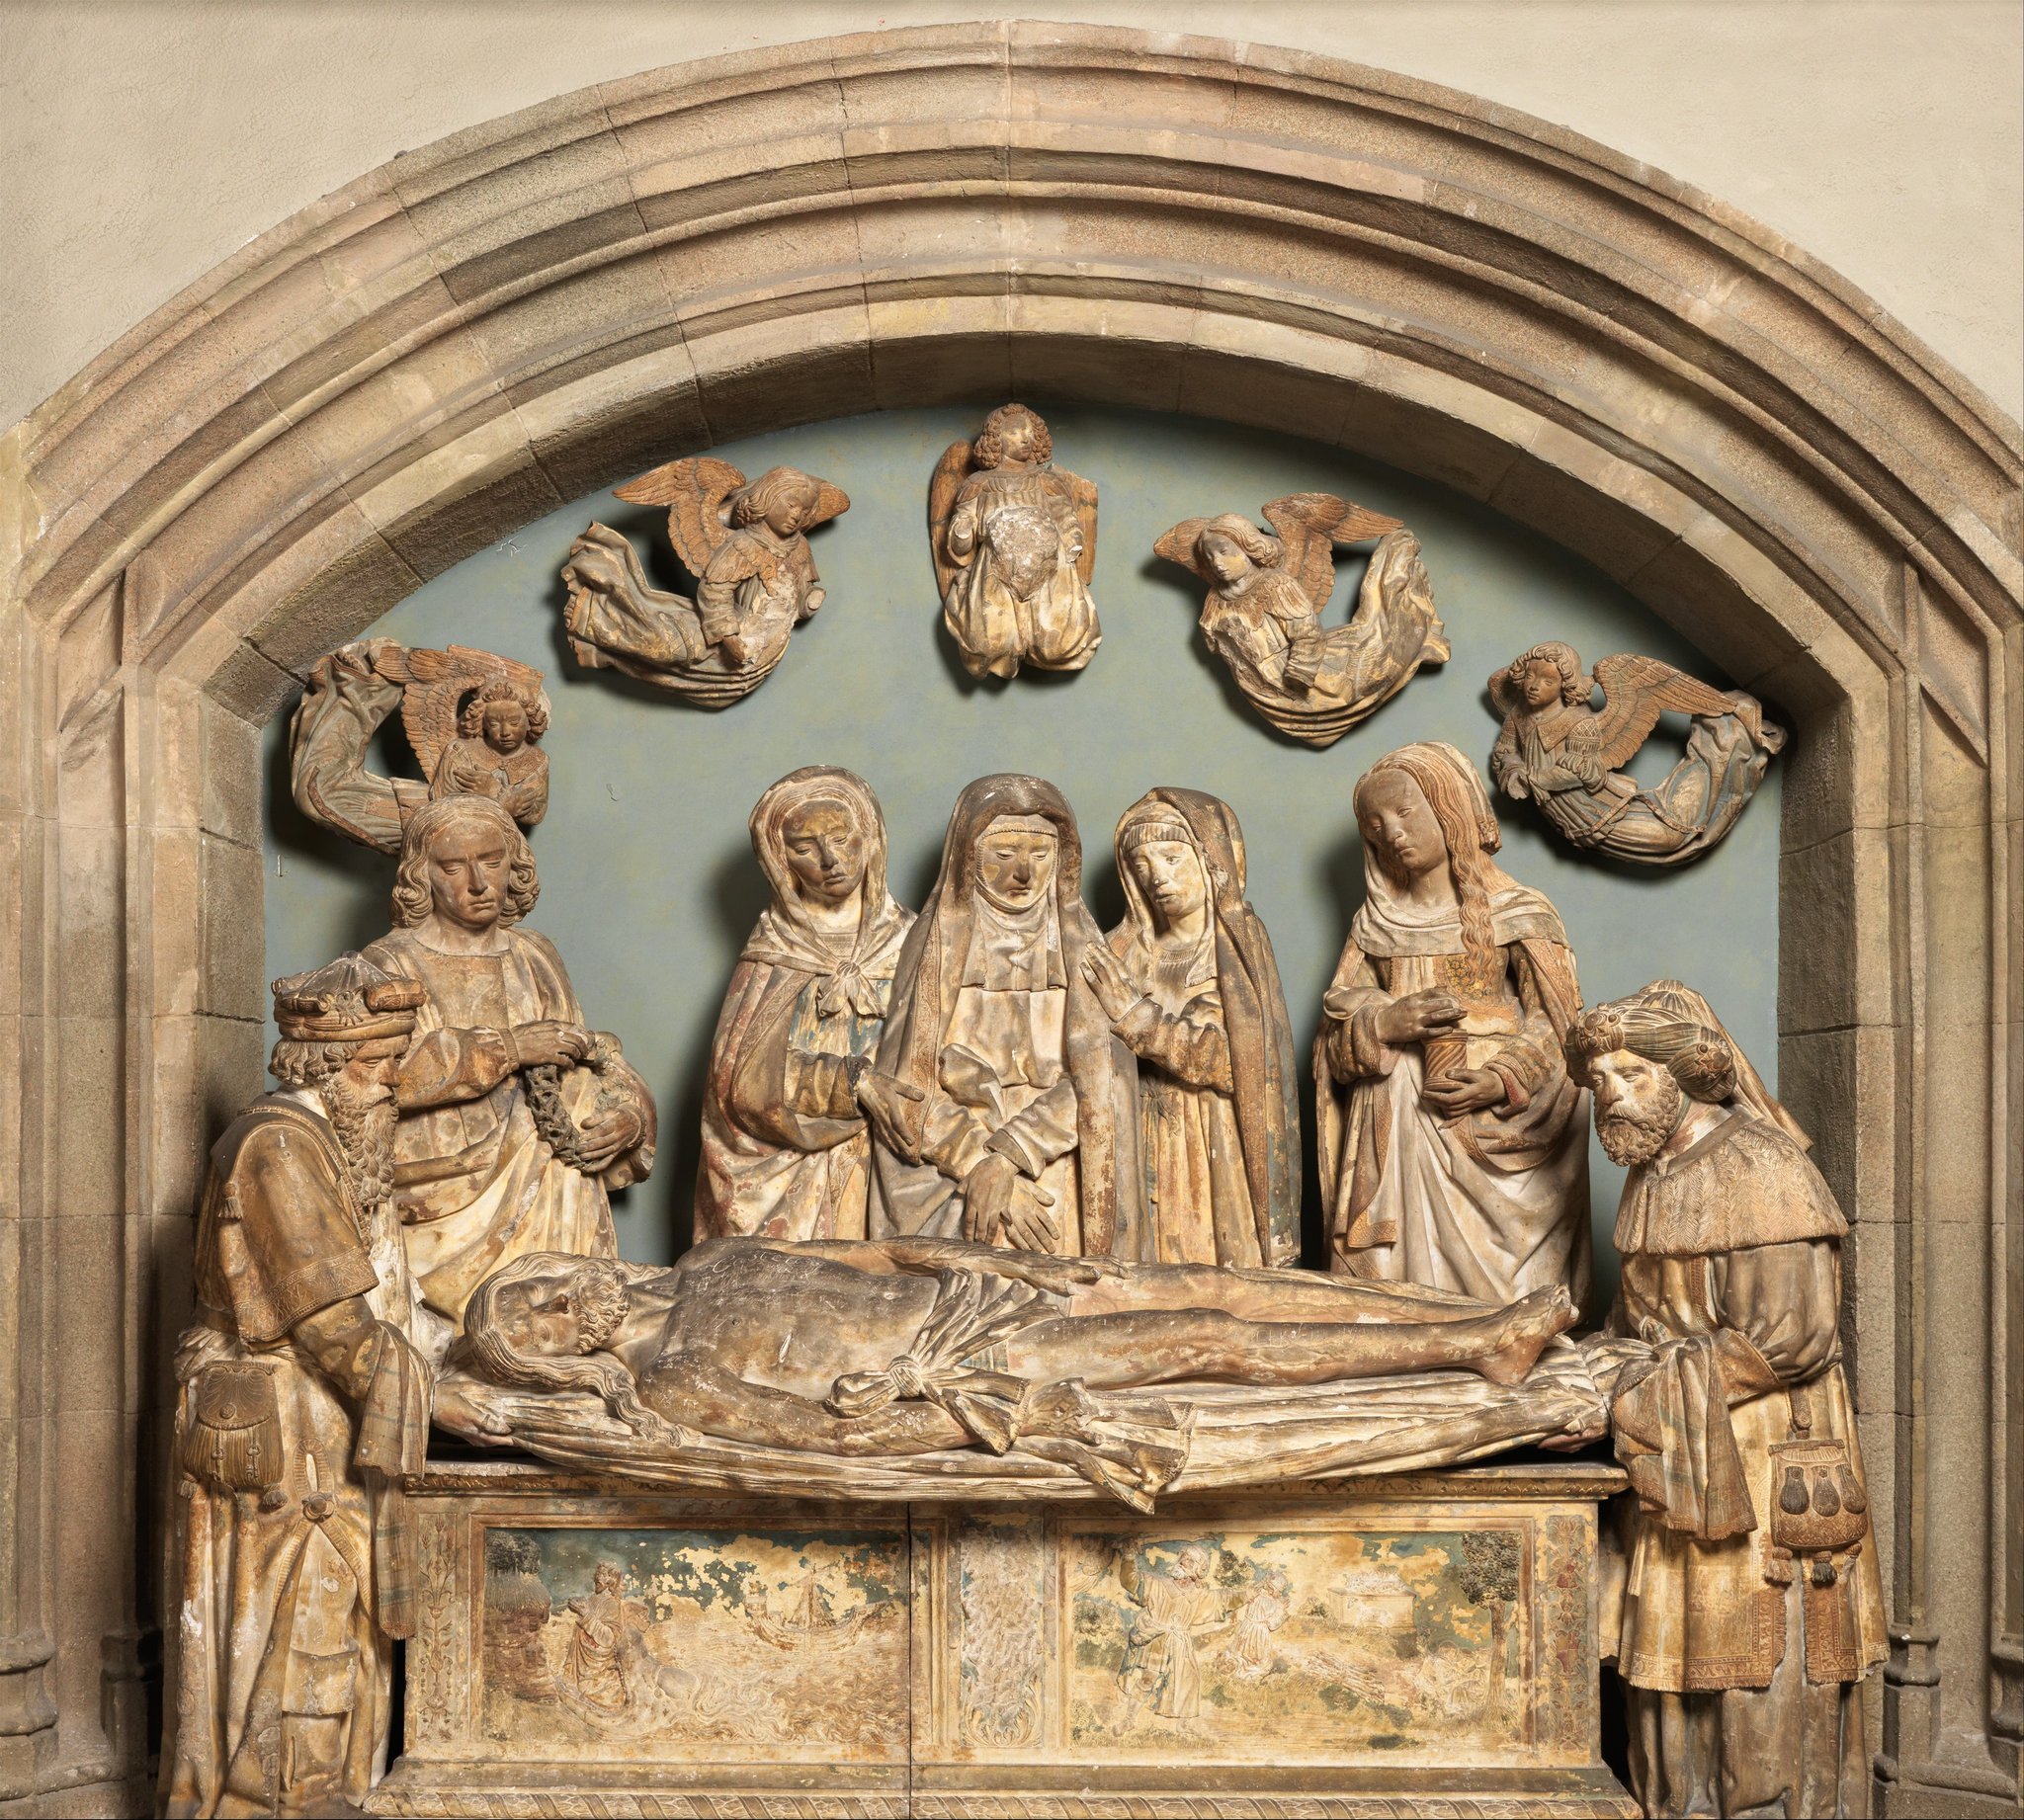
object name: sculpture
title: Entombment of Christ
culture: french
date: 1515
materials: limestone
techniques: polychromy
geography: france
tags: angels,christ,virgin mary,entombment